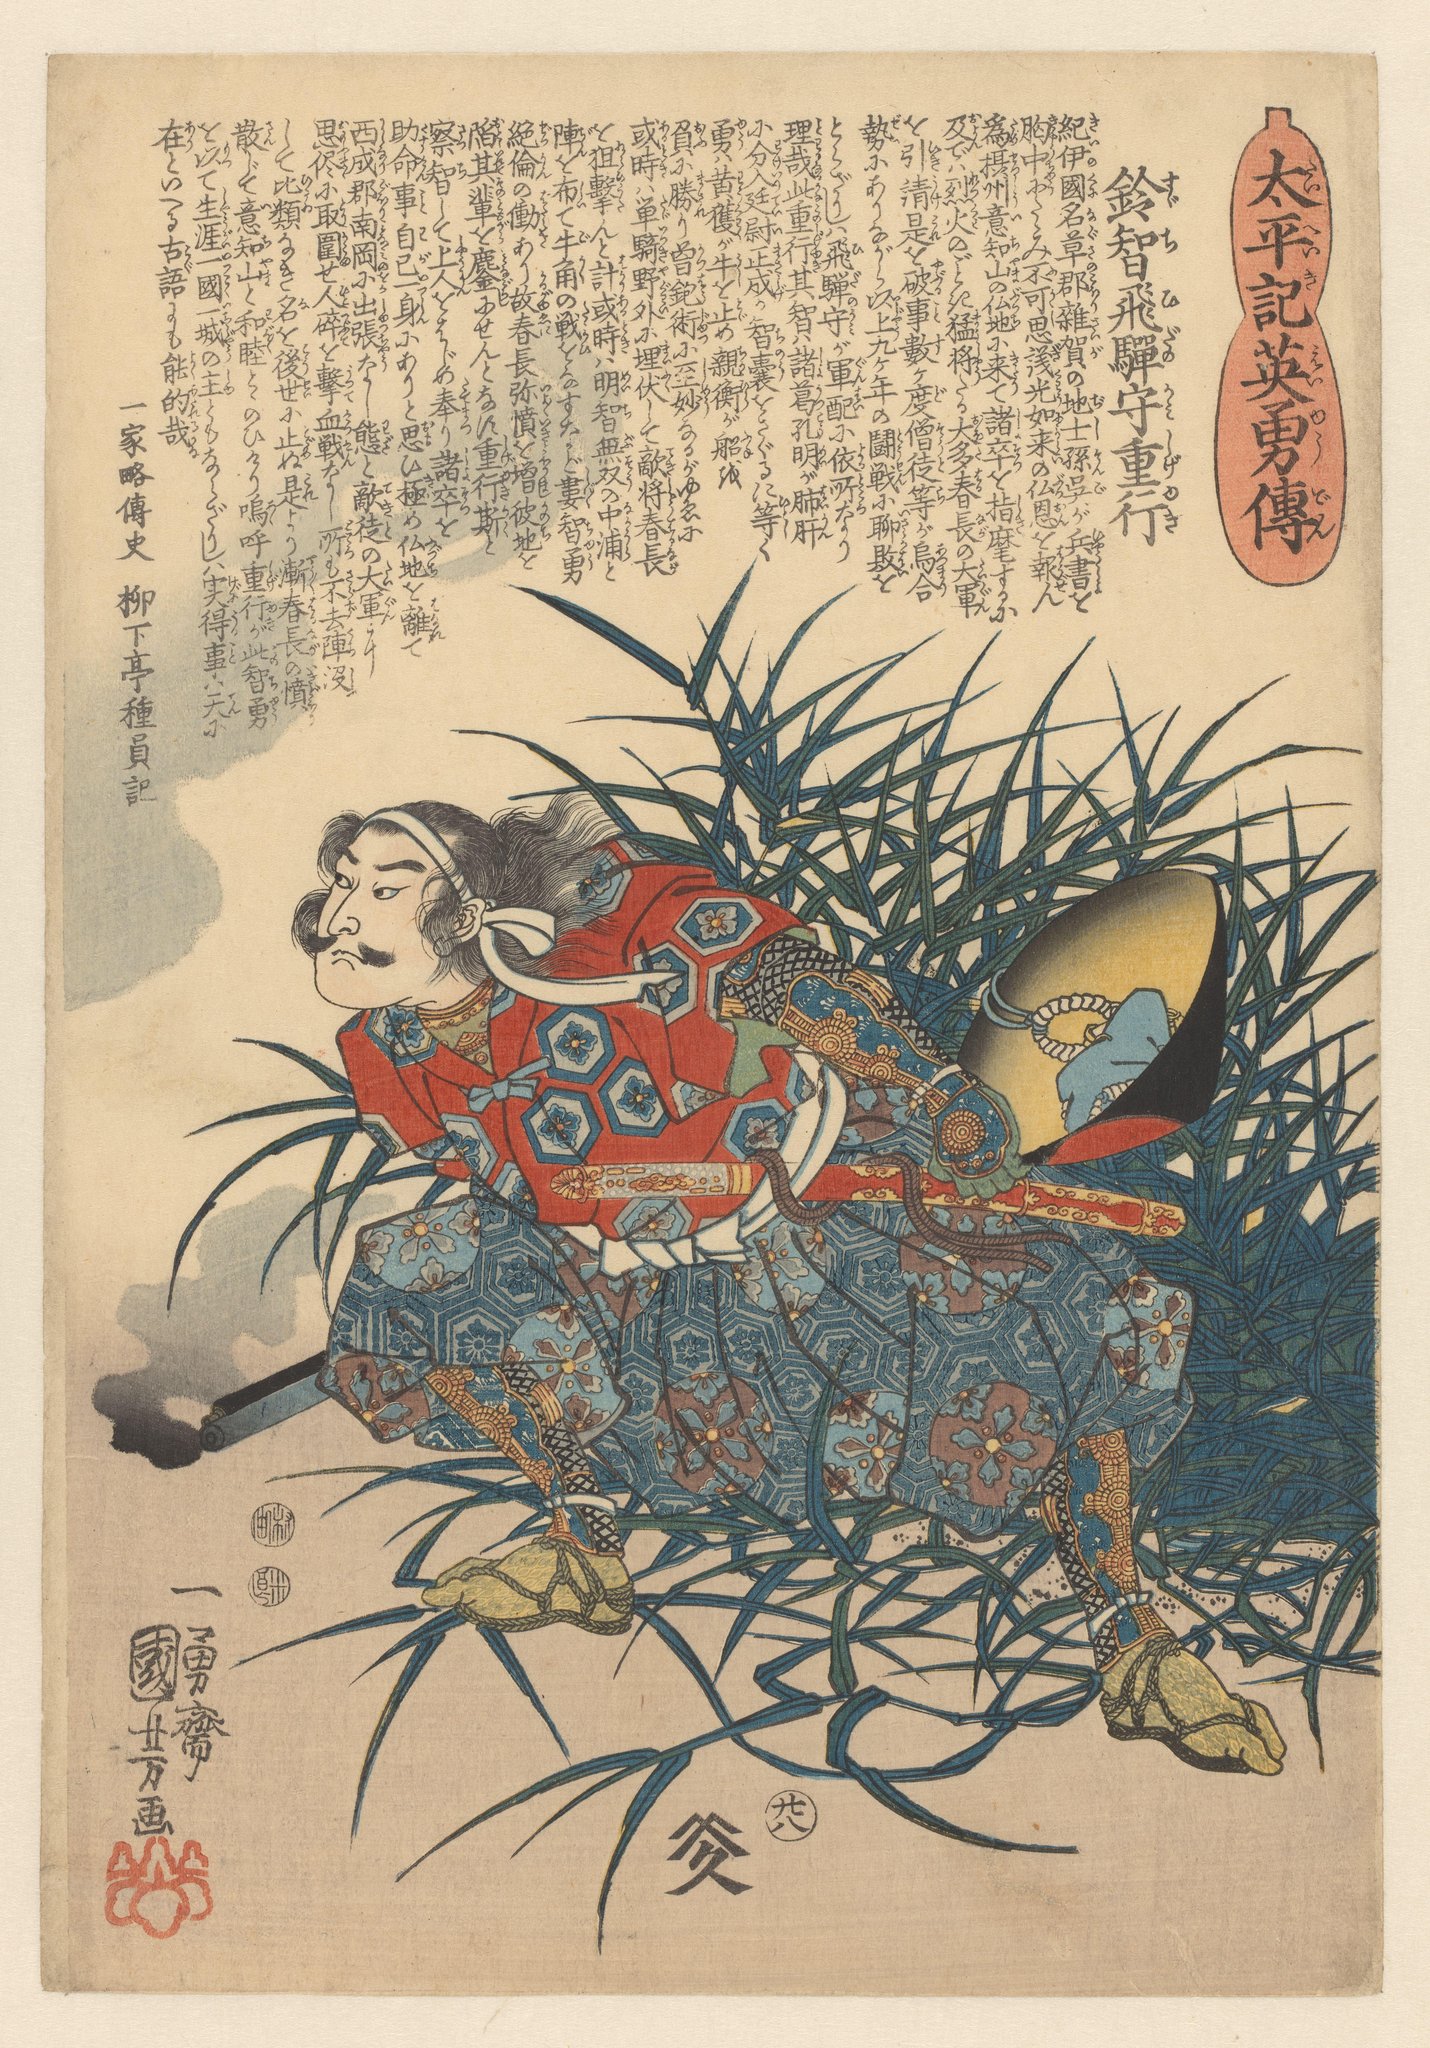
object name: print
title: Heroes of the grand pacification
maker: utagawa kuniyoshi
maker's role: draughtsman, print maker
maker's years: 1798-1861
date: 1846-1848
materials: paper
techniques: woodcut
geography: japan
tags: shrubs, adult man, hacking and thrusting weapons: sword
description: Suzuchi Hida no kami Shigeyuki met afgewaaide hoed verstopt zich onder struiken om Oda Nobunaga om te brengen.